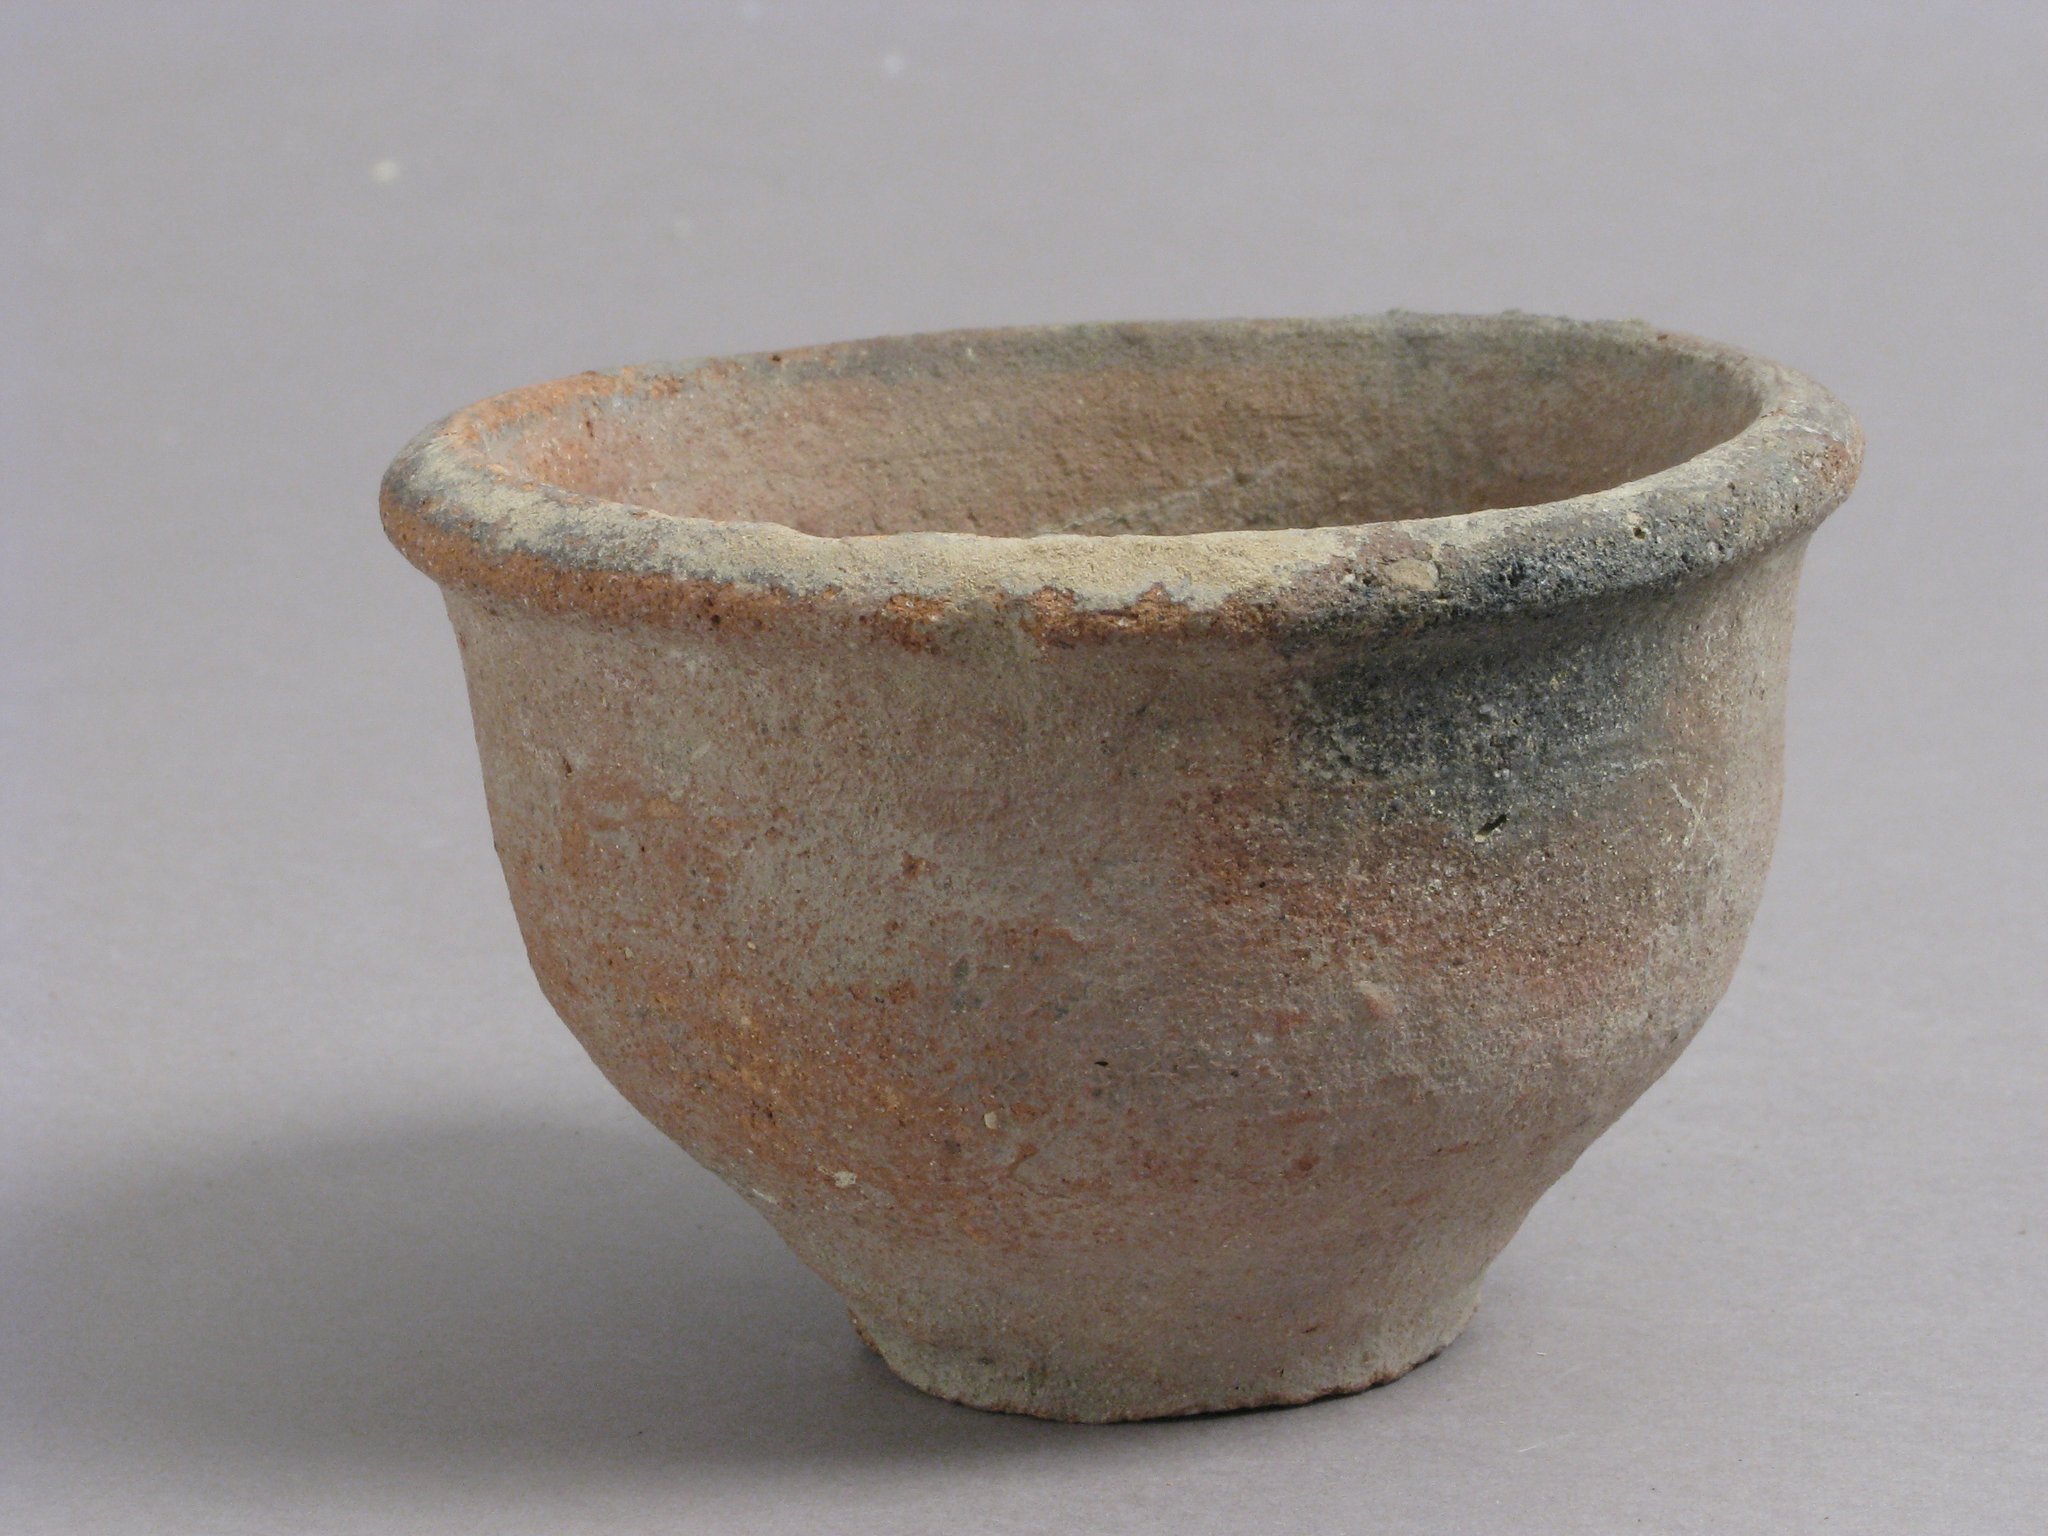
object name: bowl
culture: coptic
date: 301-700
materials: earthenware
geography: egypt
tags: bowls